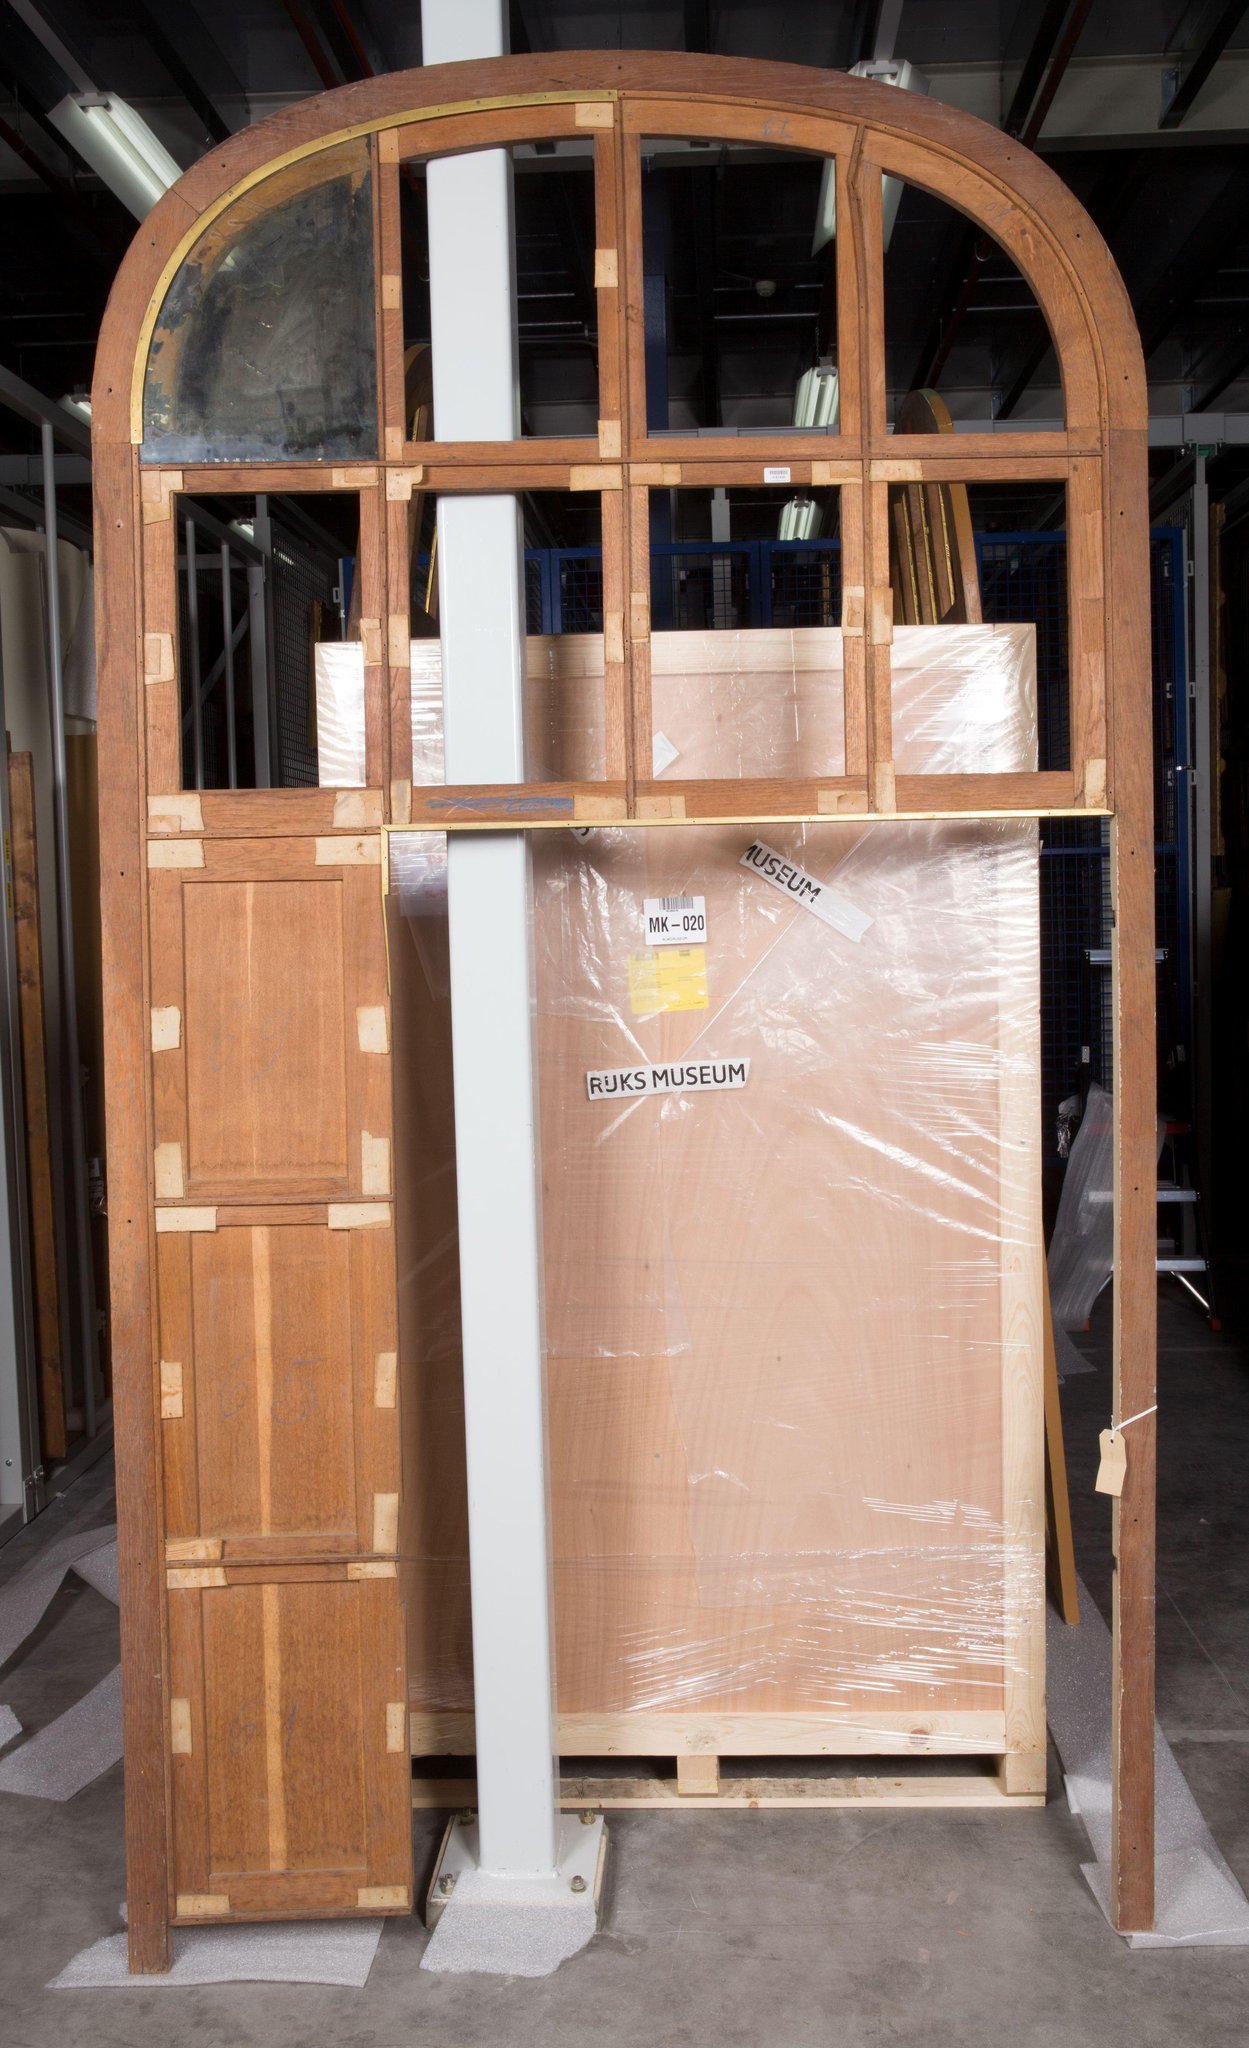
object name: mirror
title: Interieuronderdeel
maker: Anonymous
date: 1700-1750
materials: wood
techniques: gilding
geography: france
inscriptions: : ‘F1/C’